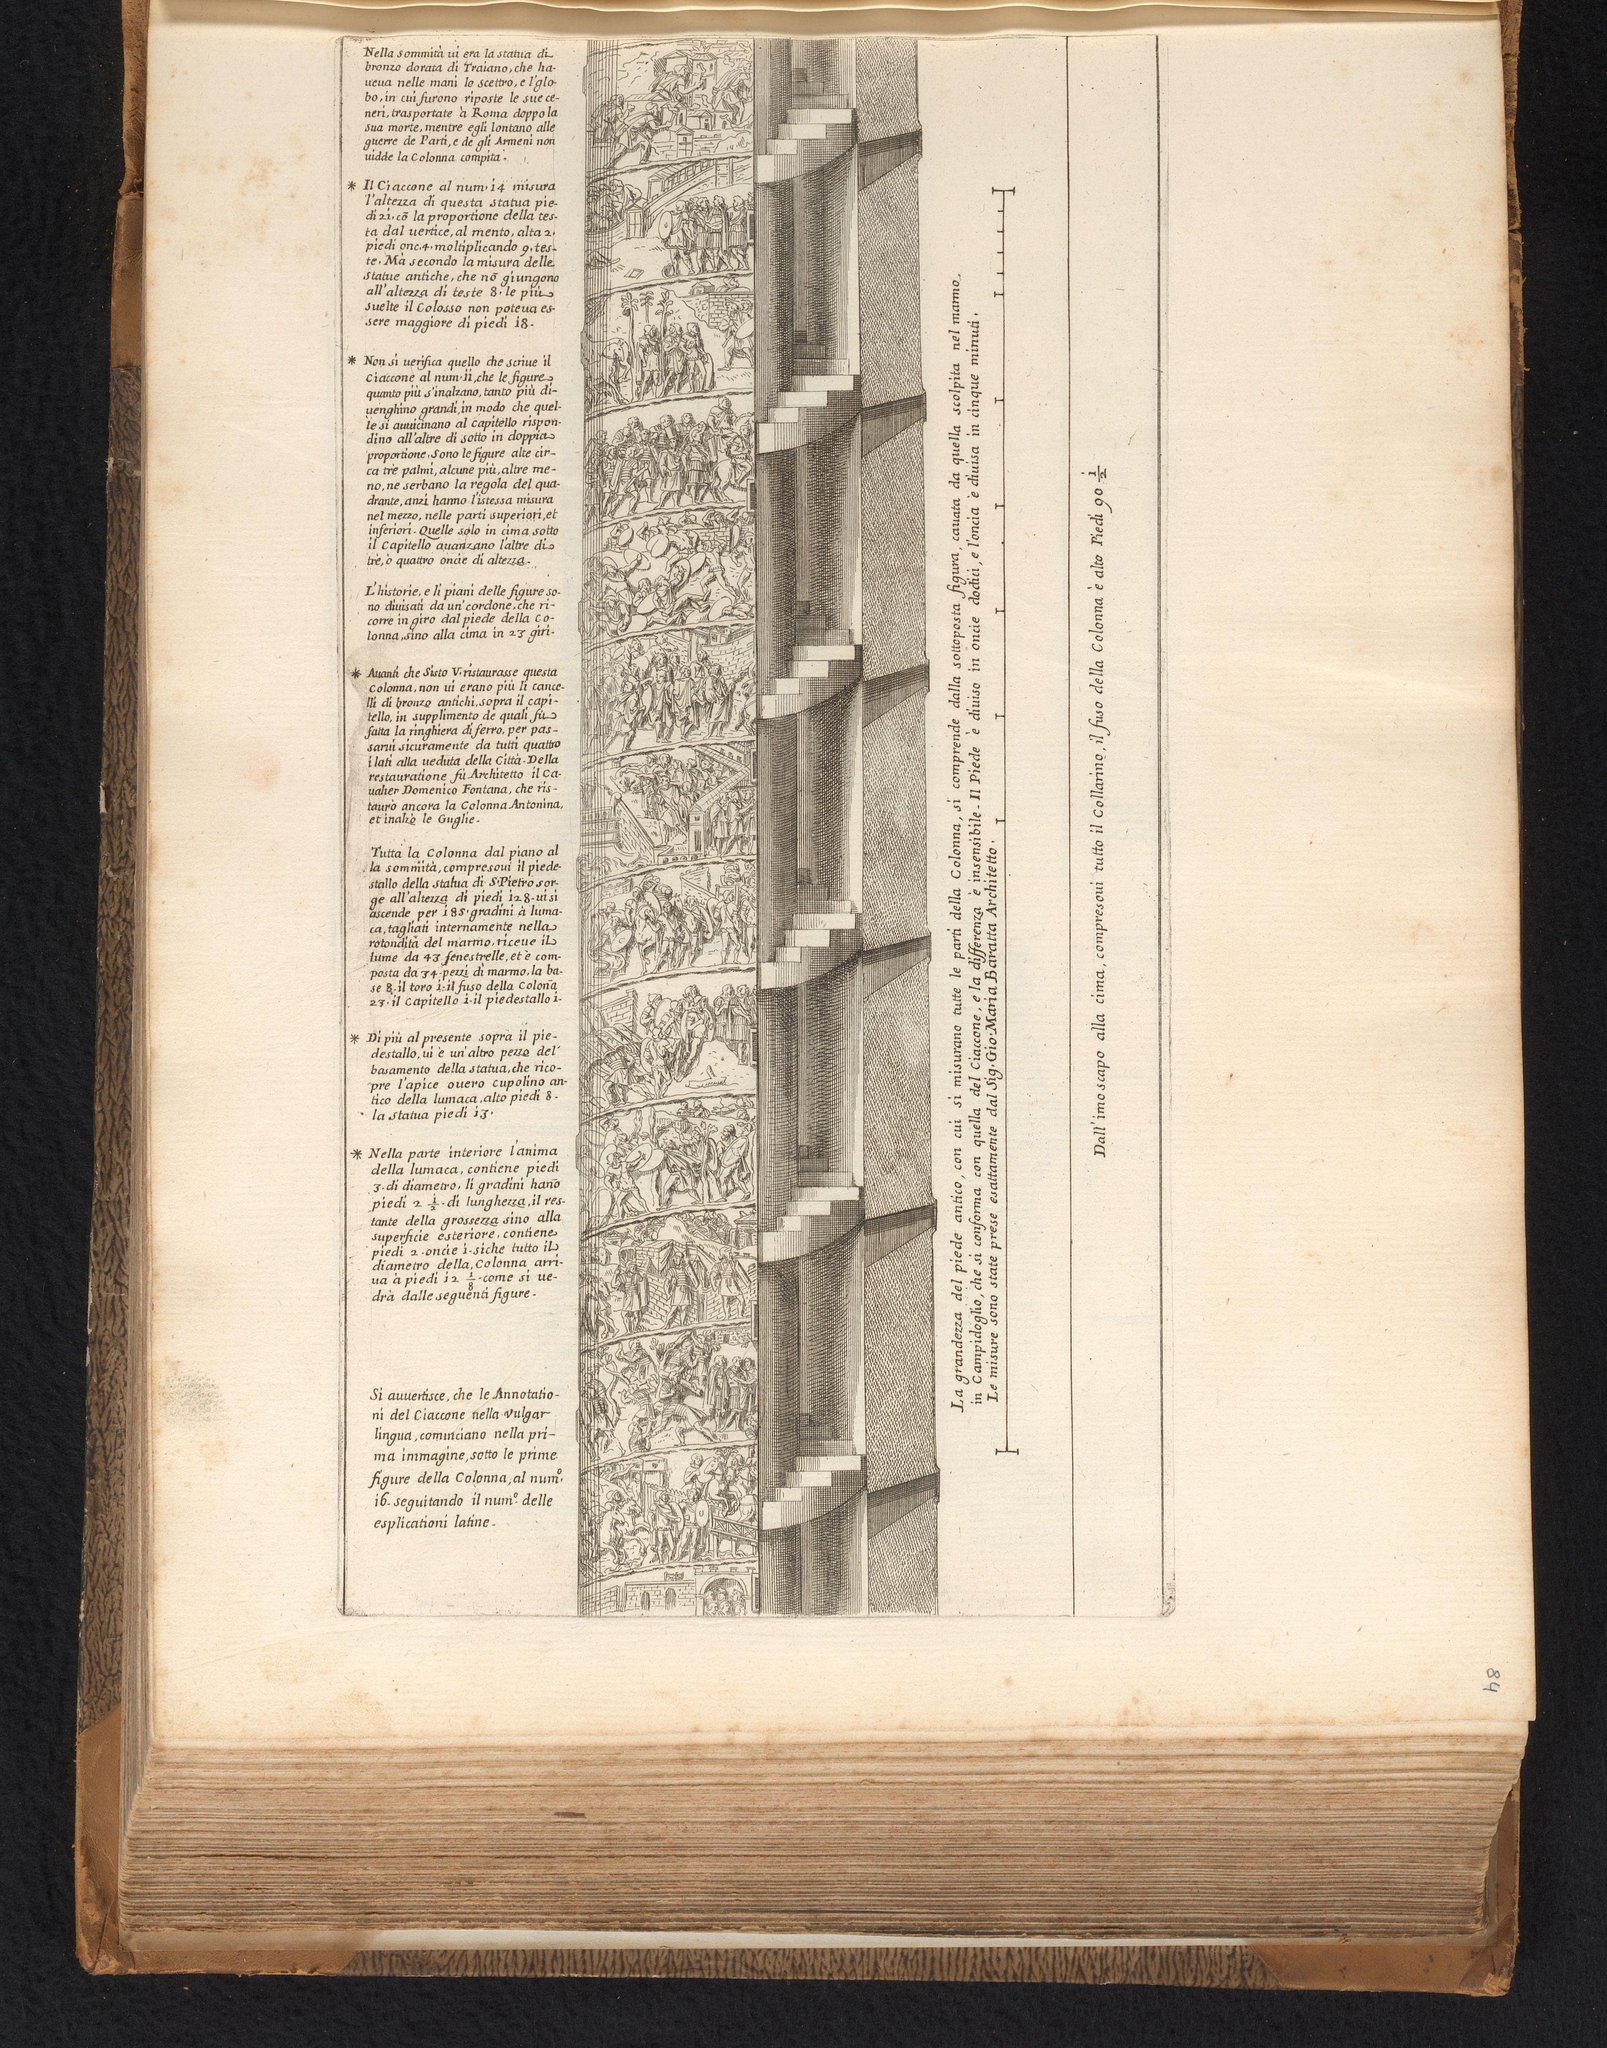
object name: print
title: Colonna Traiana eretta dal senato, e popolo Romano all' imperatore Traiano Augusto nel suo foro in Rom (...)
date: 1637-1691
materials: paper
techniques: etching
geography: rome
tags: triumphal column with helical friezes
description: Deze prent maakt deel uit van een reeks van 128 prenten(+ titelprent) (alleen de 119 prenten met details van het grote fries zijn genummerd) met voorstellingen van de Zuil van Trajanus.